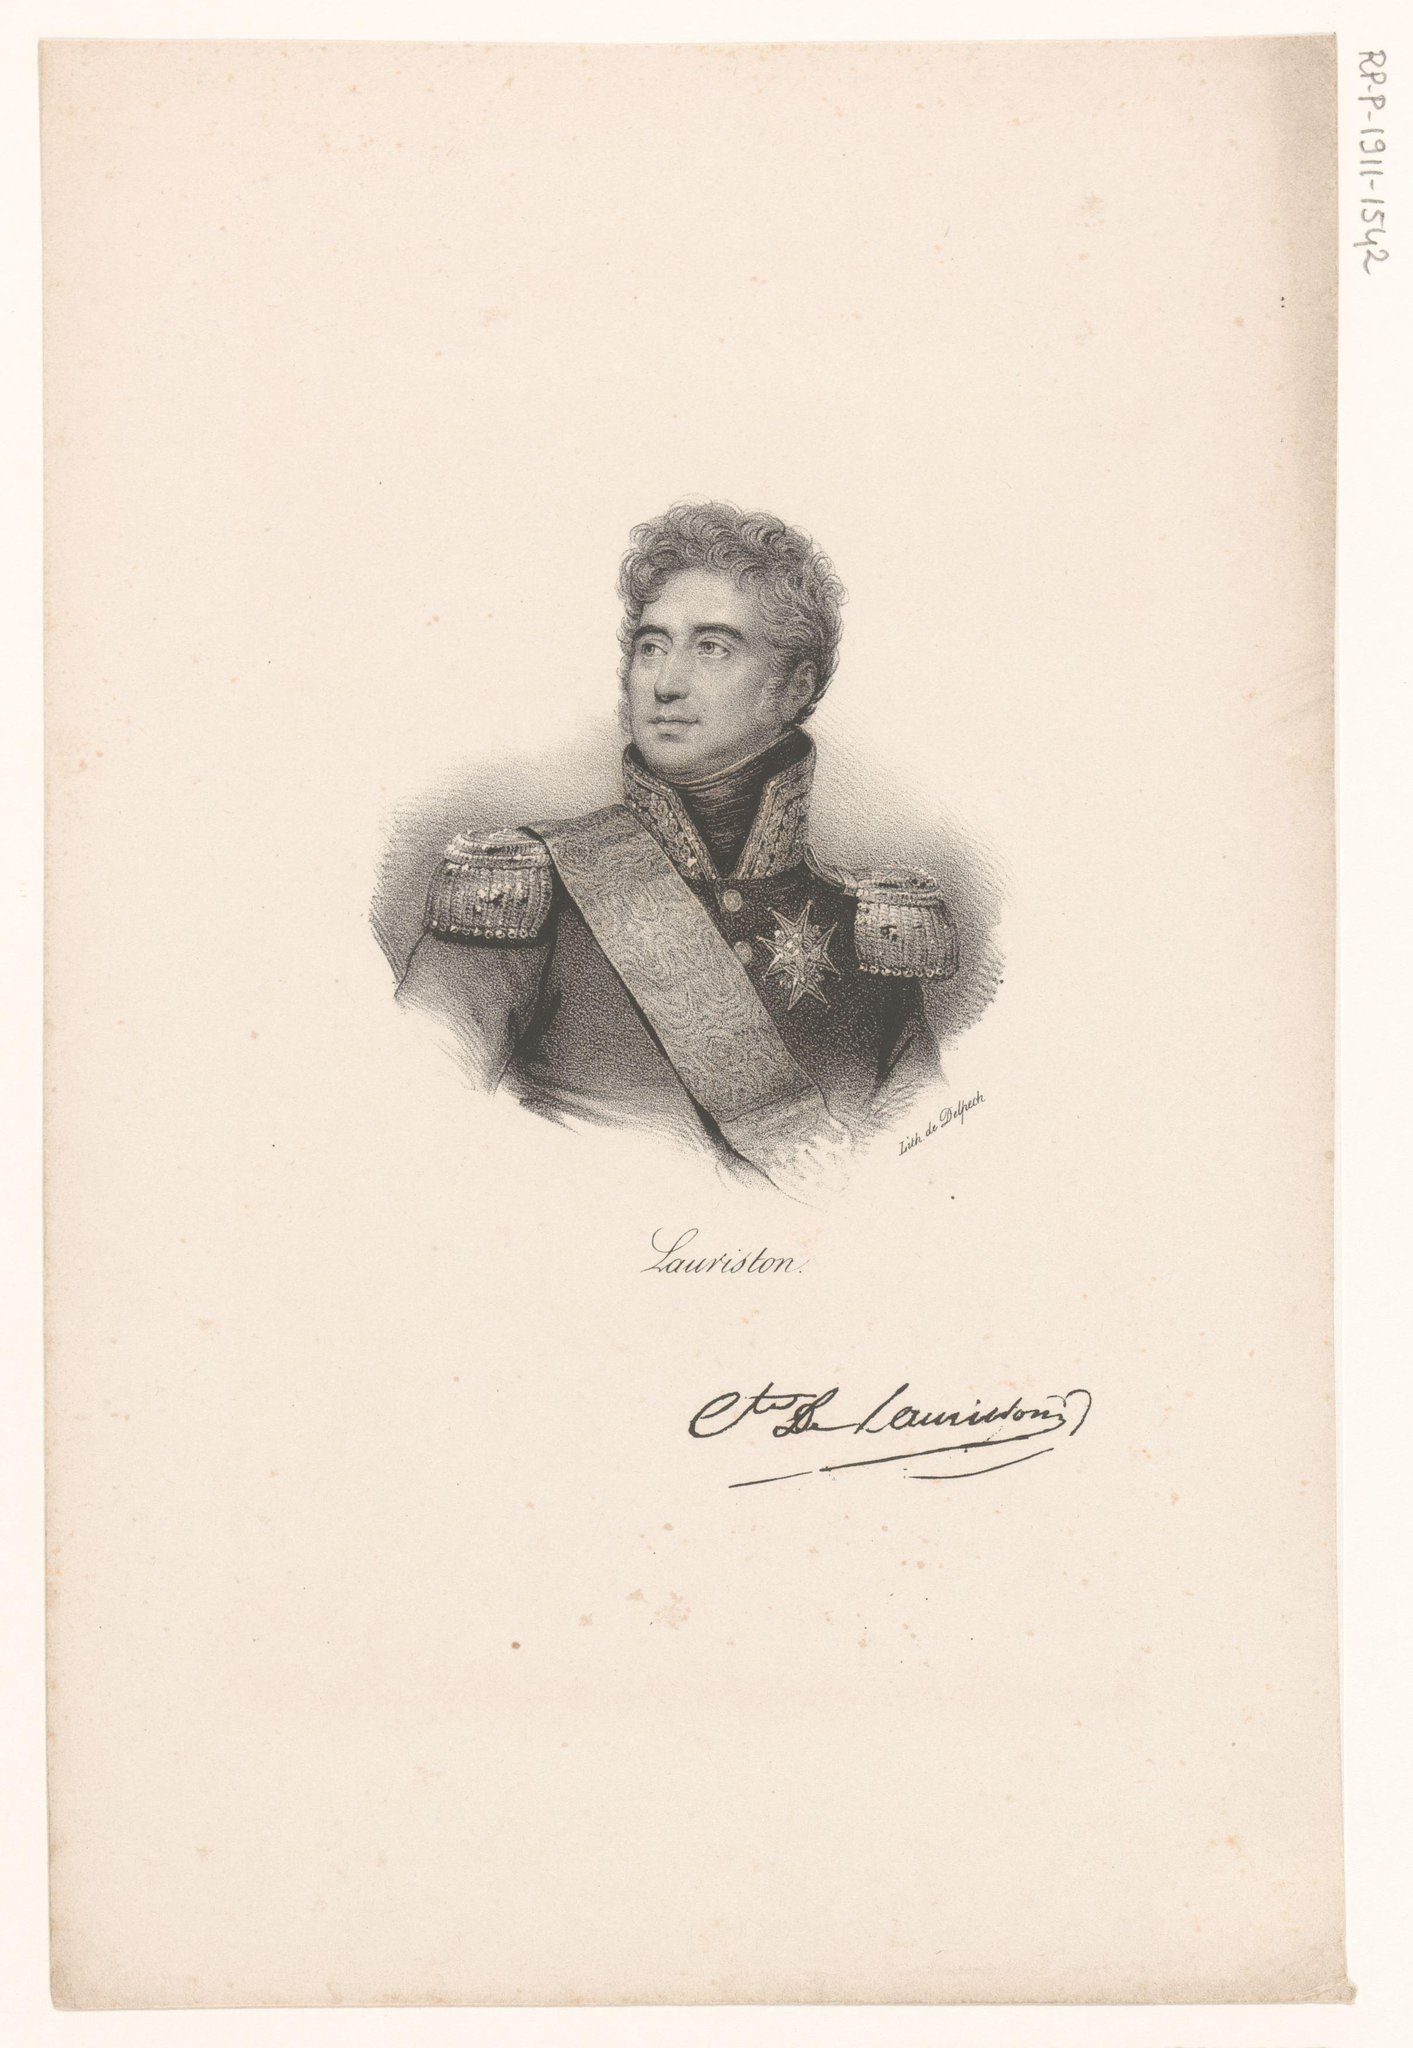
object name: print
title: Lauriston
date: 1818-1842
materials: paper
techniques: lithograph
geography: paris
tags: paris, politician, historical persons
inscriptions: collector's mark: Lugt 2228a